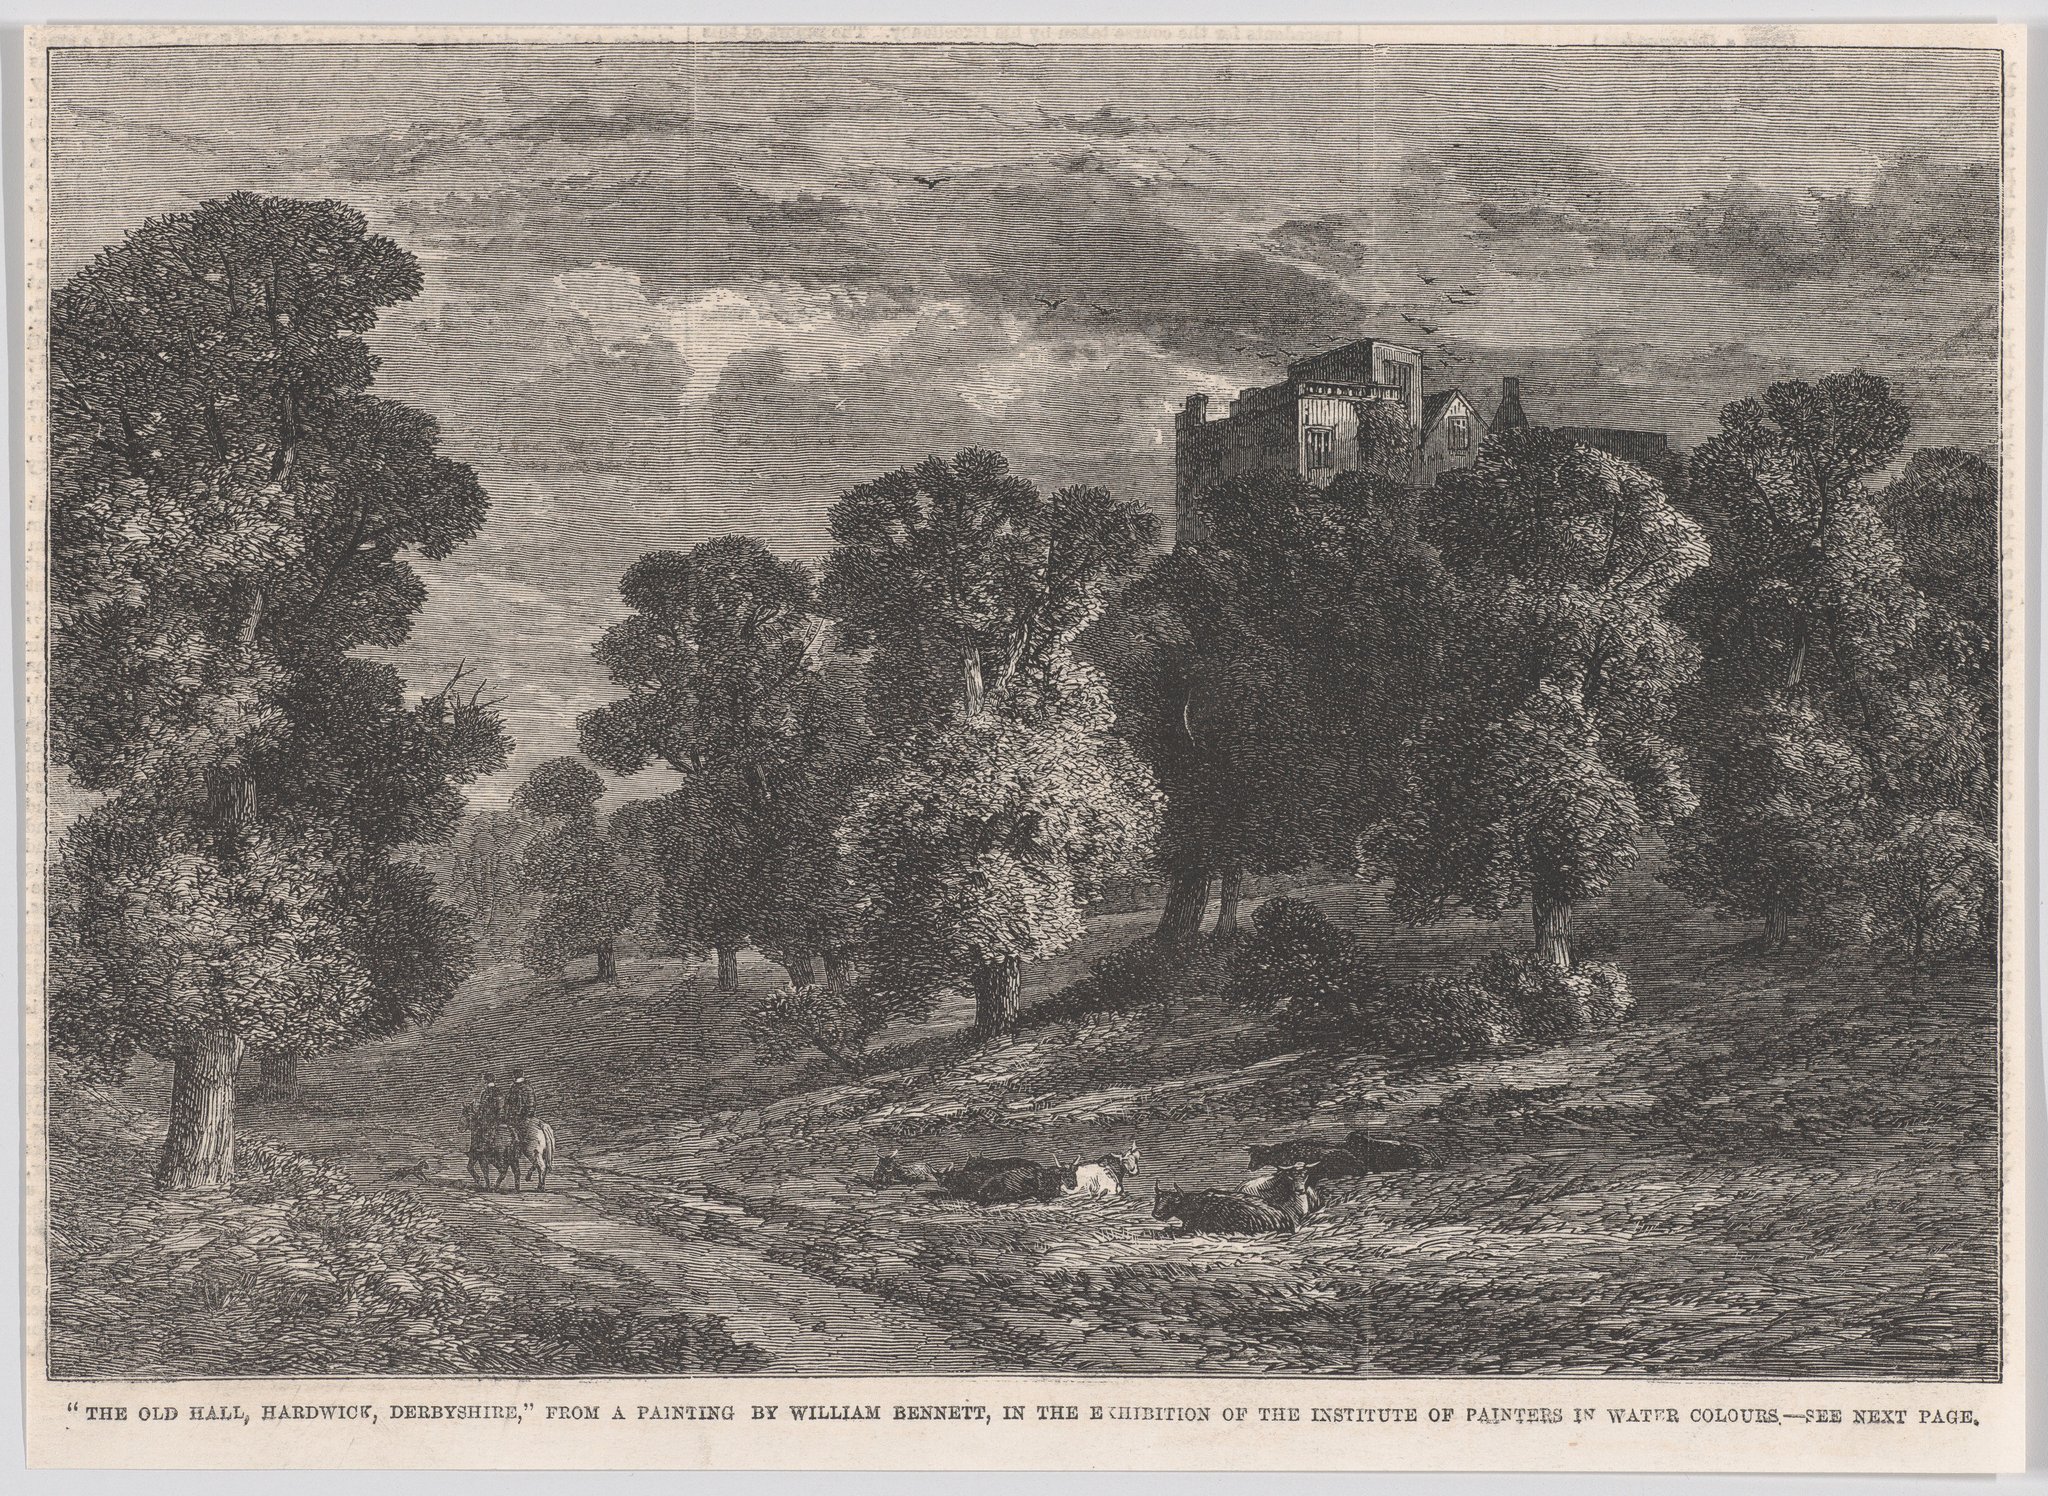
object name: print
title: The Old Hall, Hardwick, Derbyshire, from "Illustrated London News"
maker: william bennett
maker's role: artist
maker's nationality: british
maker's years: 1811-1871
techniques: engraving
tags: roads,horses,trees